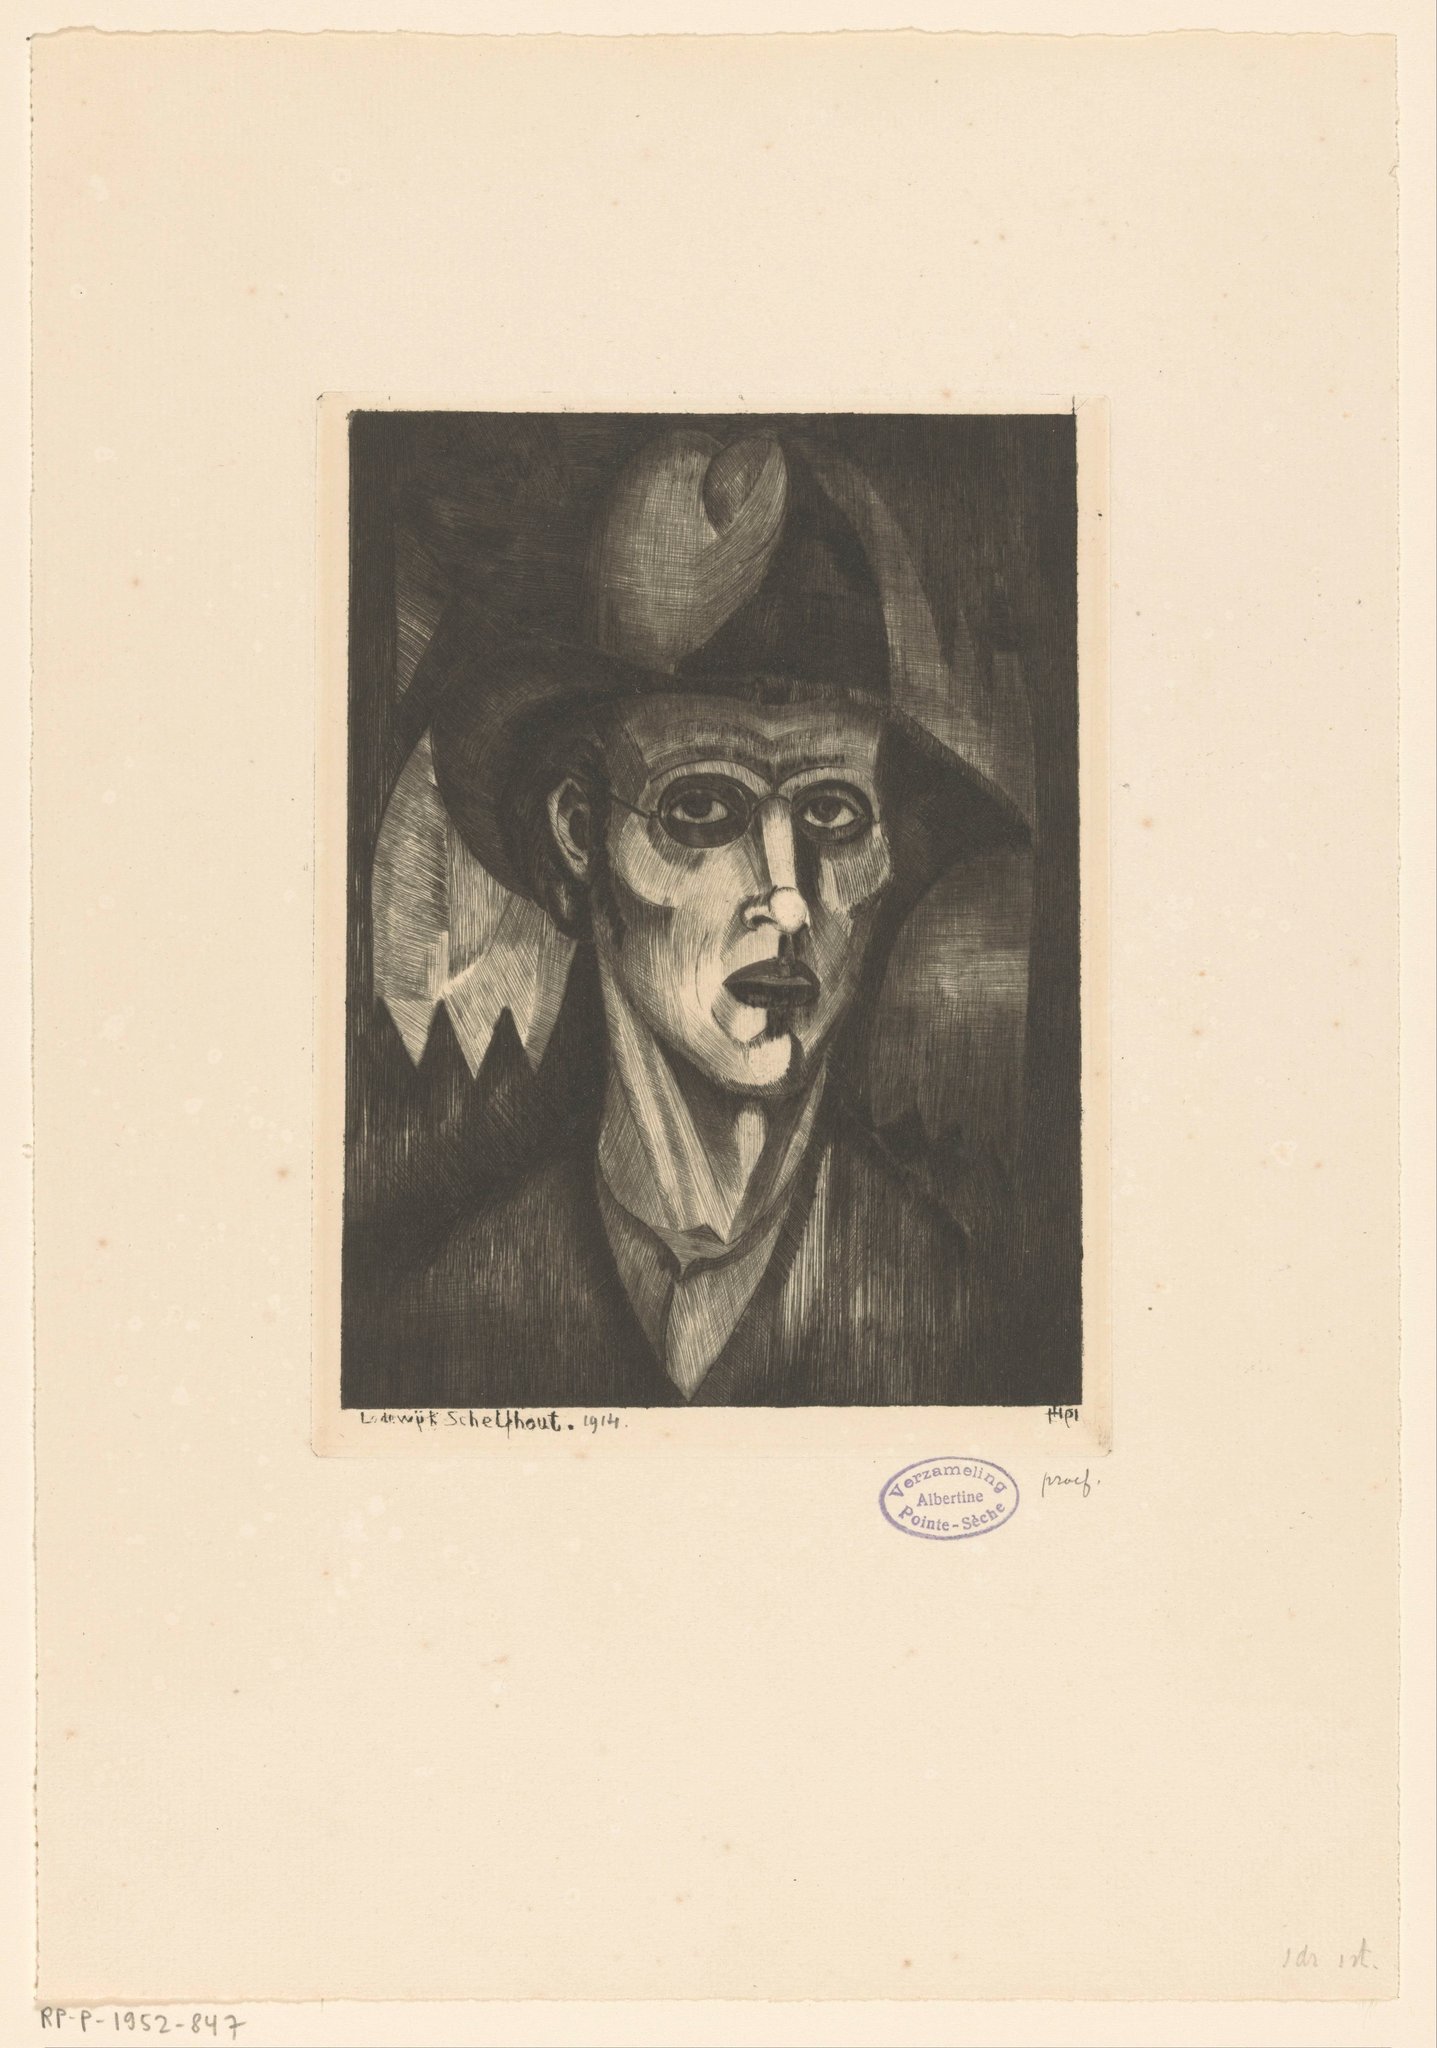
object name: print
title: Man met hoed en bril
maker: lodewijk schelfhout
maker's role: draughtsman, print maker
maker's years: 1881-1943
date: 1914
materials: paper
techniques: drypoint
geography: netherlands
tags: head-gear: hat (+ men's clothes)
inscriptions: collector's mark: Lugt 2228, collector's mark: Lugt 2760, collector's mark: Lugt 5i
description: Volgens mededeling van kleinzoon Patrick Raken (06.01.2020) betreft dit een zelfportret van Lodewijk Schelfhout